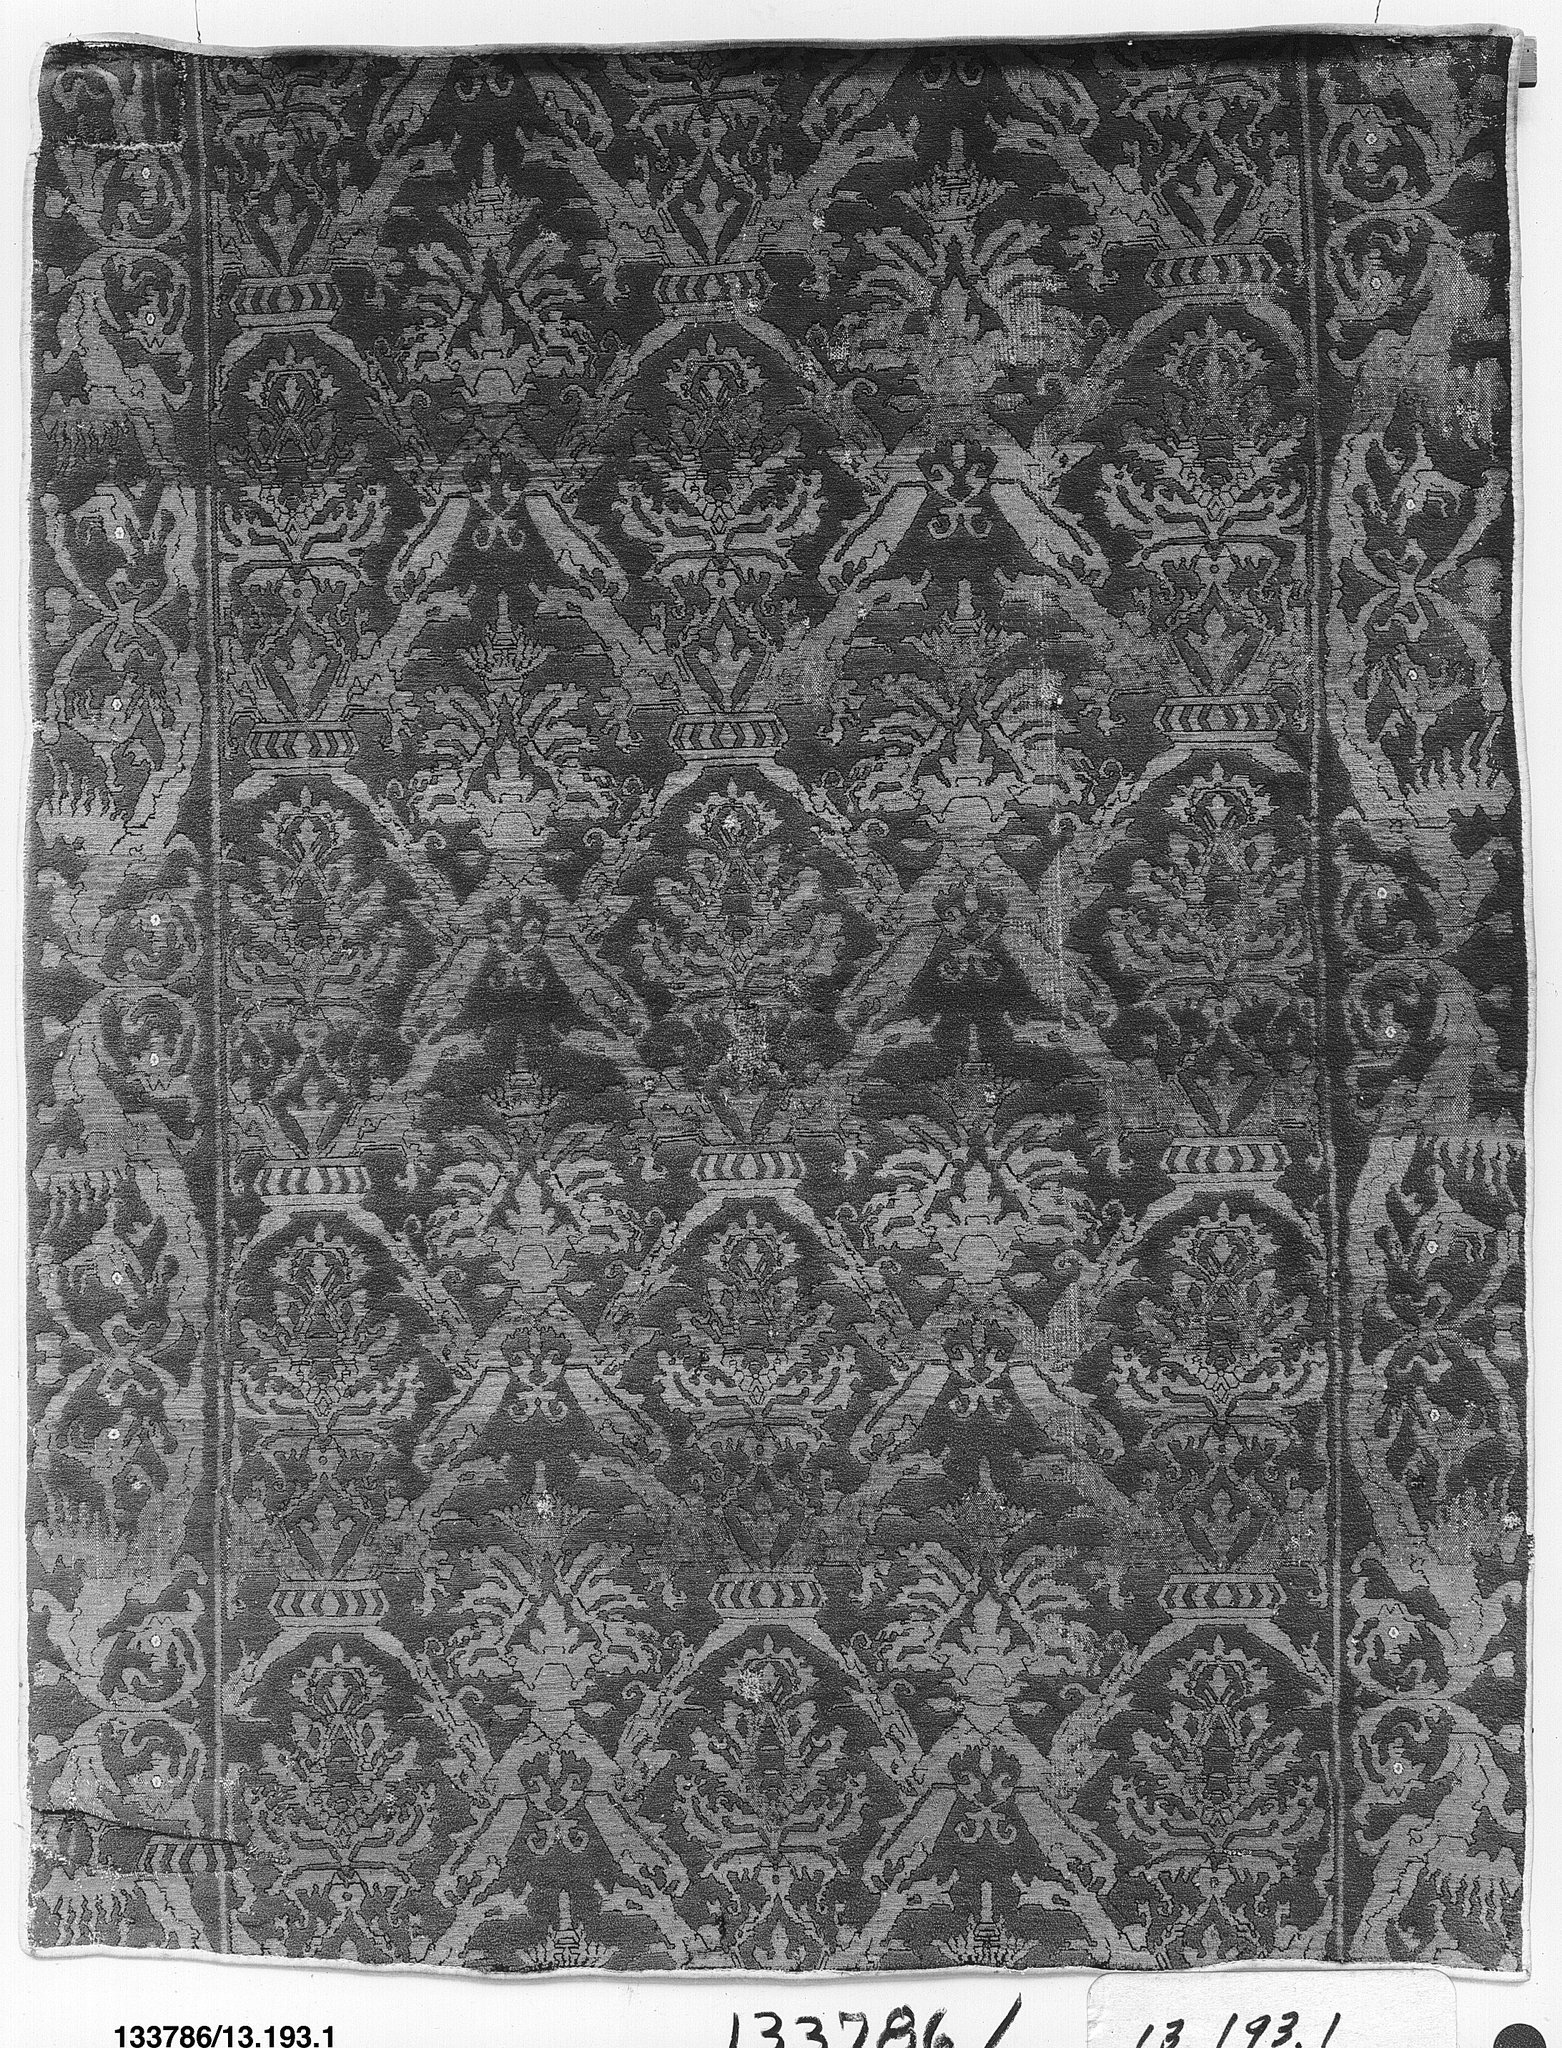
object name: rug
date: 1501-1550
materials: wool